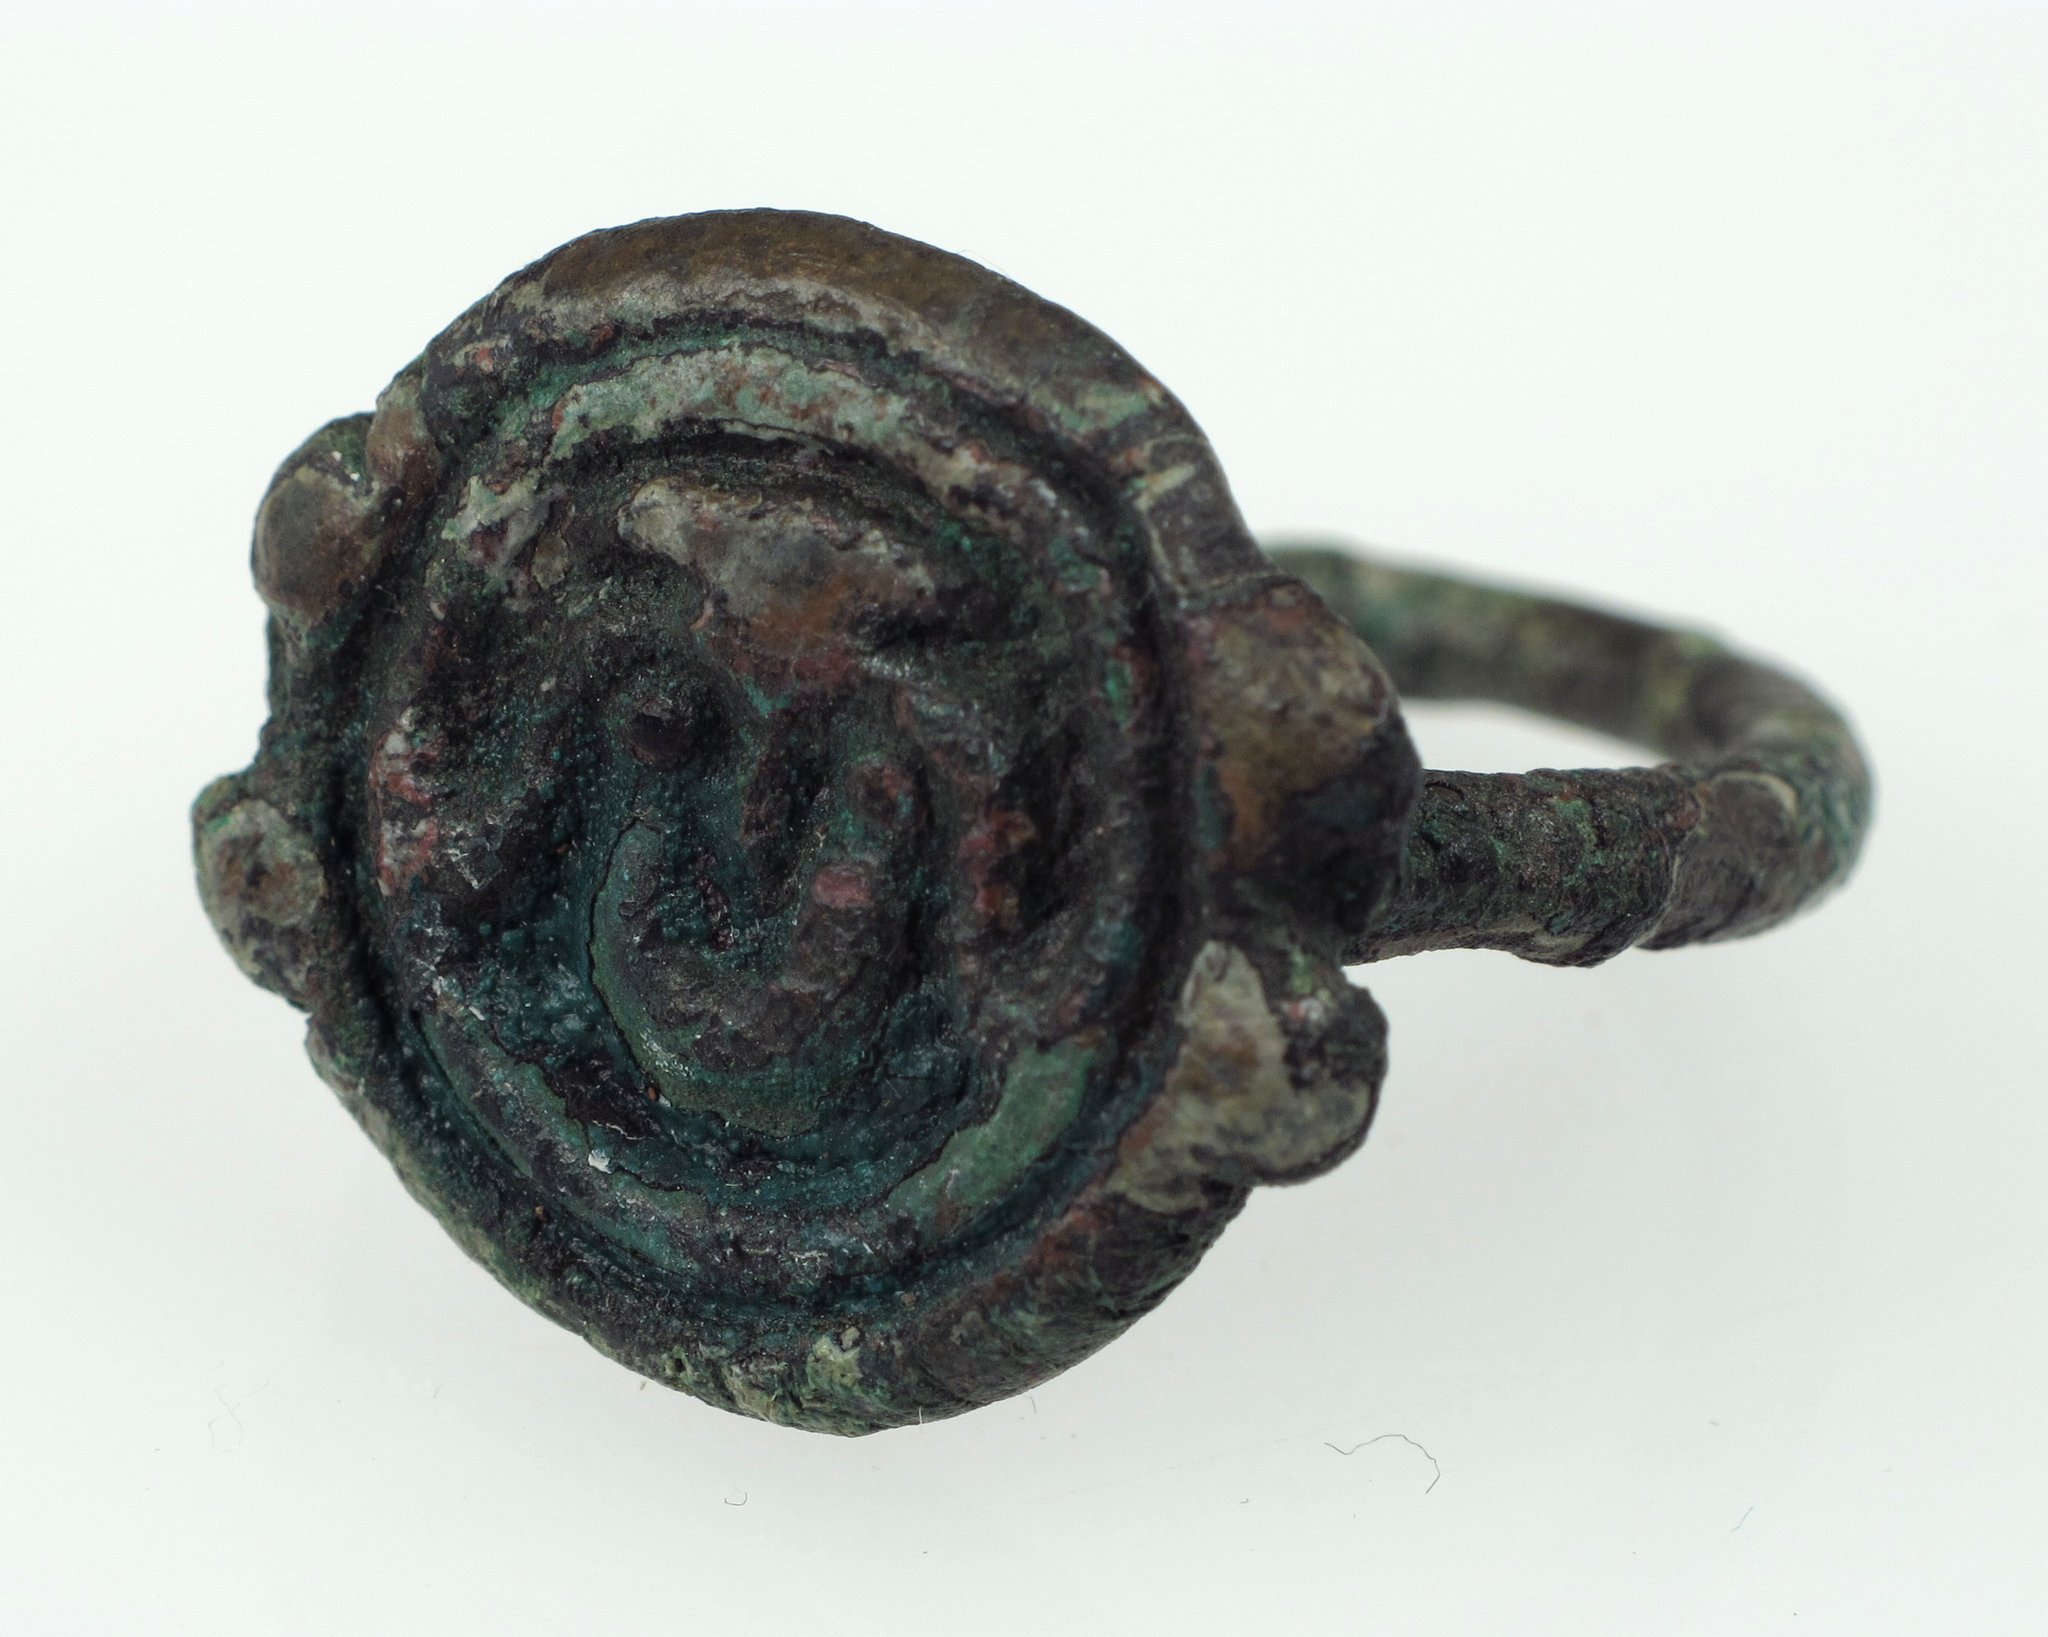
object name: ring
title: Finger ring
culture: langobardic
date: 501-700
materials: bronze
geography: italy